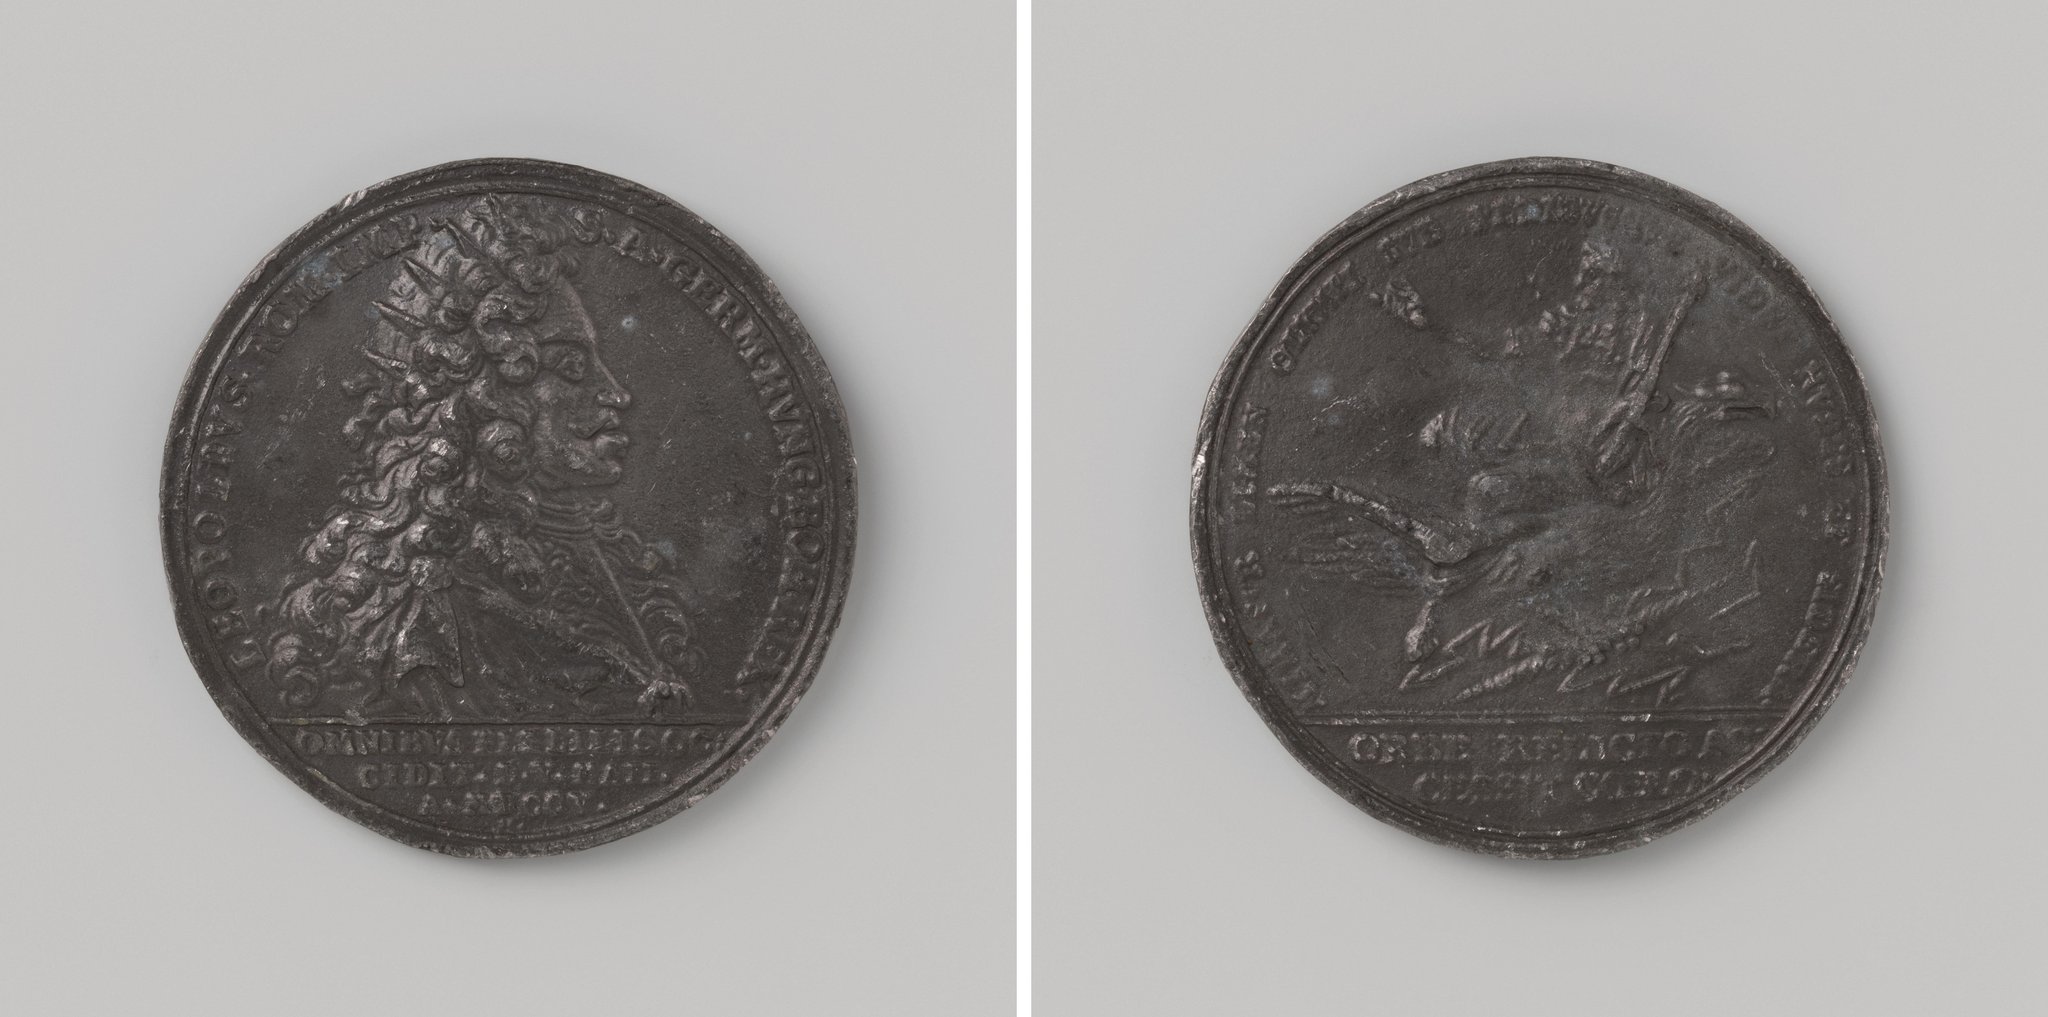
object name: copy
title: Overlijden van keizer Leopold I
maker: Anonymous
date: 1705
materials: lead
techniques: casting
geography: nuremberg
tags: leopold i (keizer van duitsland)